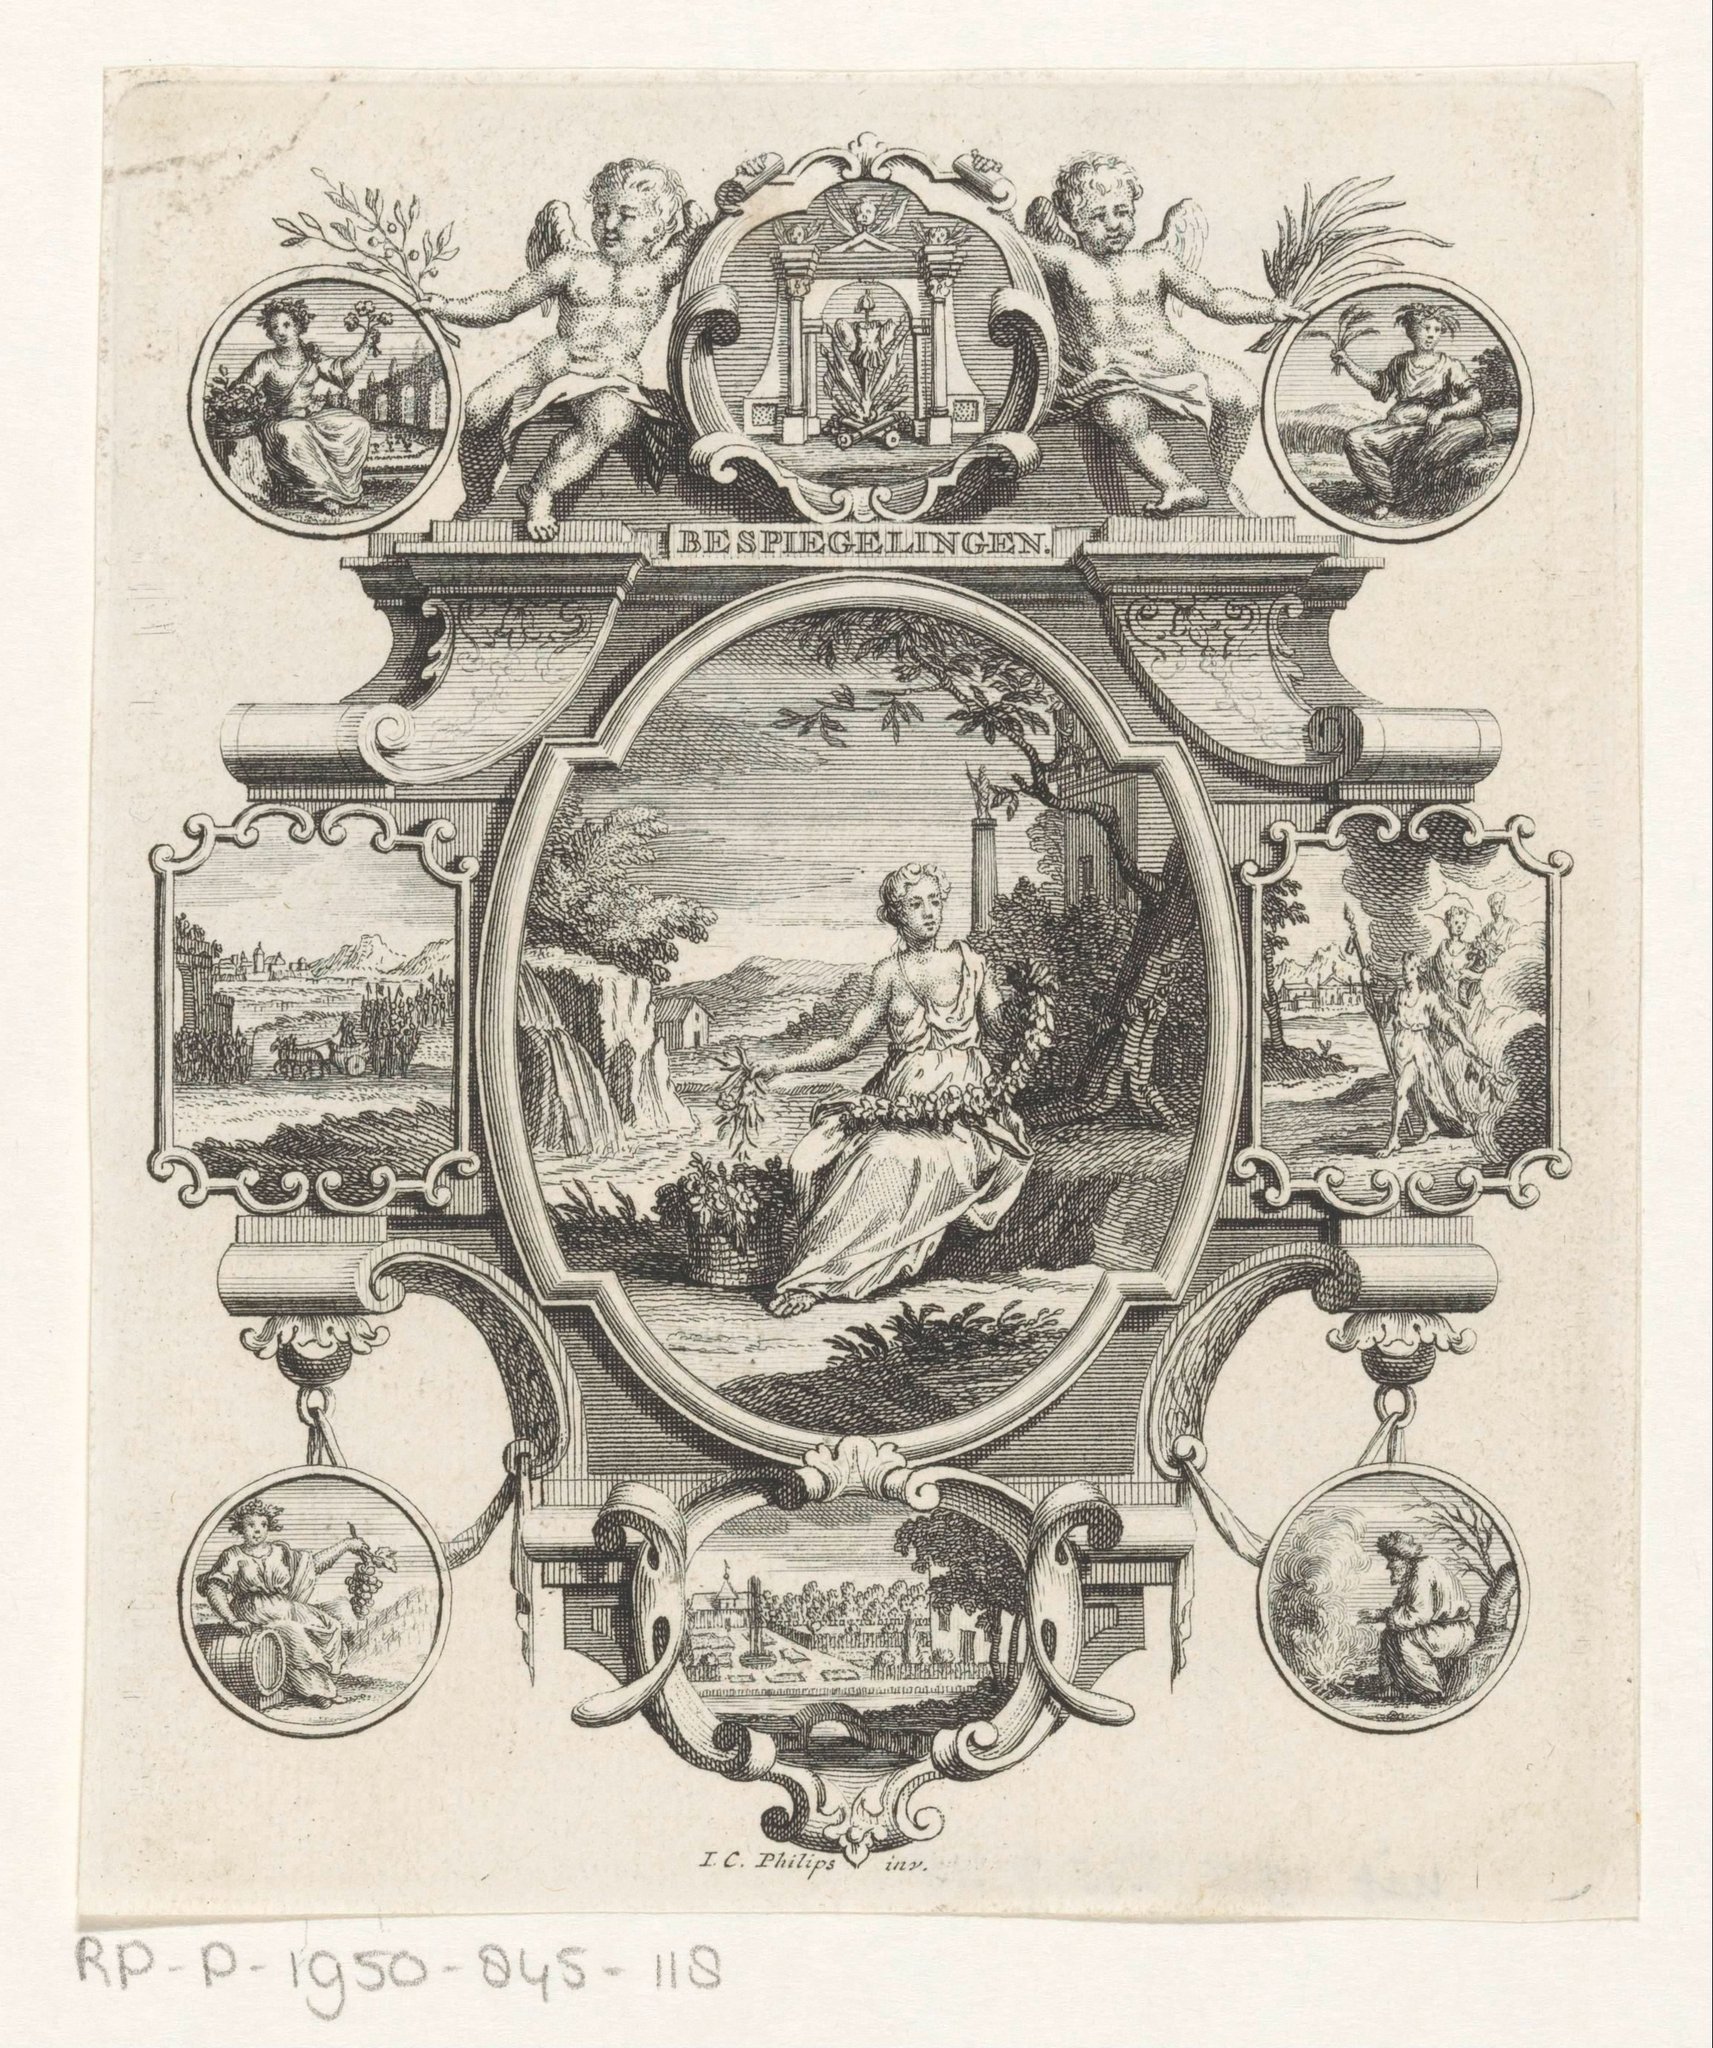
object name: book illustration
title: Bespiegelingen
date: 1769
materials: paper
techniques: engraving, etching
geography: amsterdam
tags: seasons of the year (esp. personifications); 'stagione', 'le quattro stagione dell'anno' (ripa), ornament ~ cartouche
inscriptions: collector's mark: Lugt 2228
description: Prent uit: Engelberts, E.M. Bespiegelingen over de vier getijden des jaars. Amsterdam: Yntema & Tiboel, 1769. Prent afkomstig uit een plakalbum met titelprenten, ornamenten etc. op blauw papier in 1983 uit elkaar gehaald. Volgens een notitie op verso zat de prent op p. 118 van dit album.